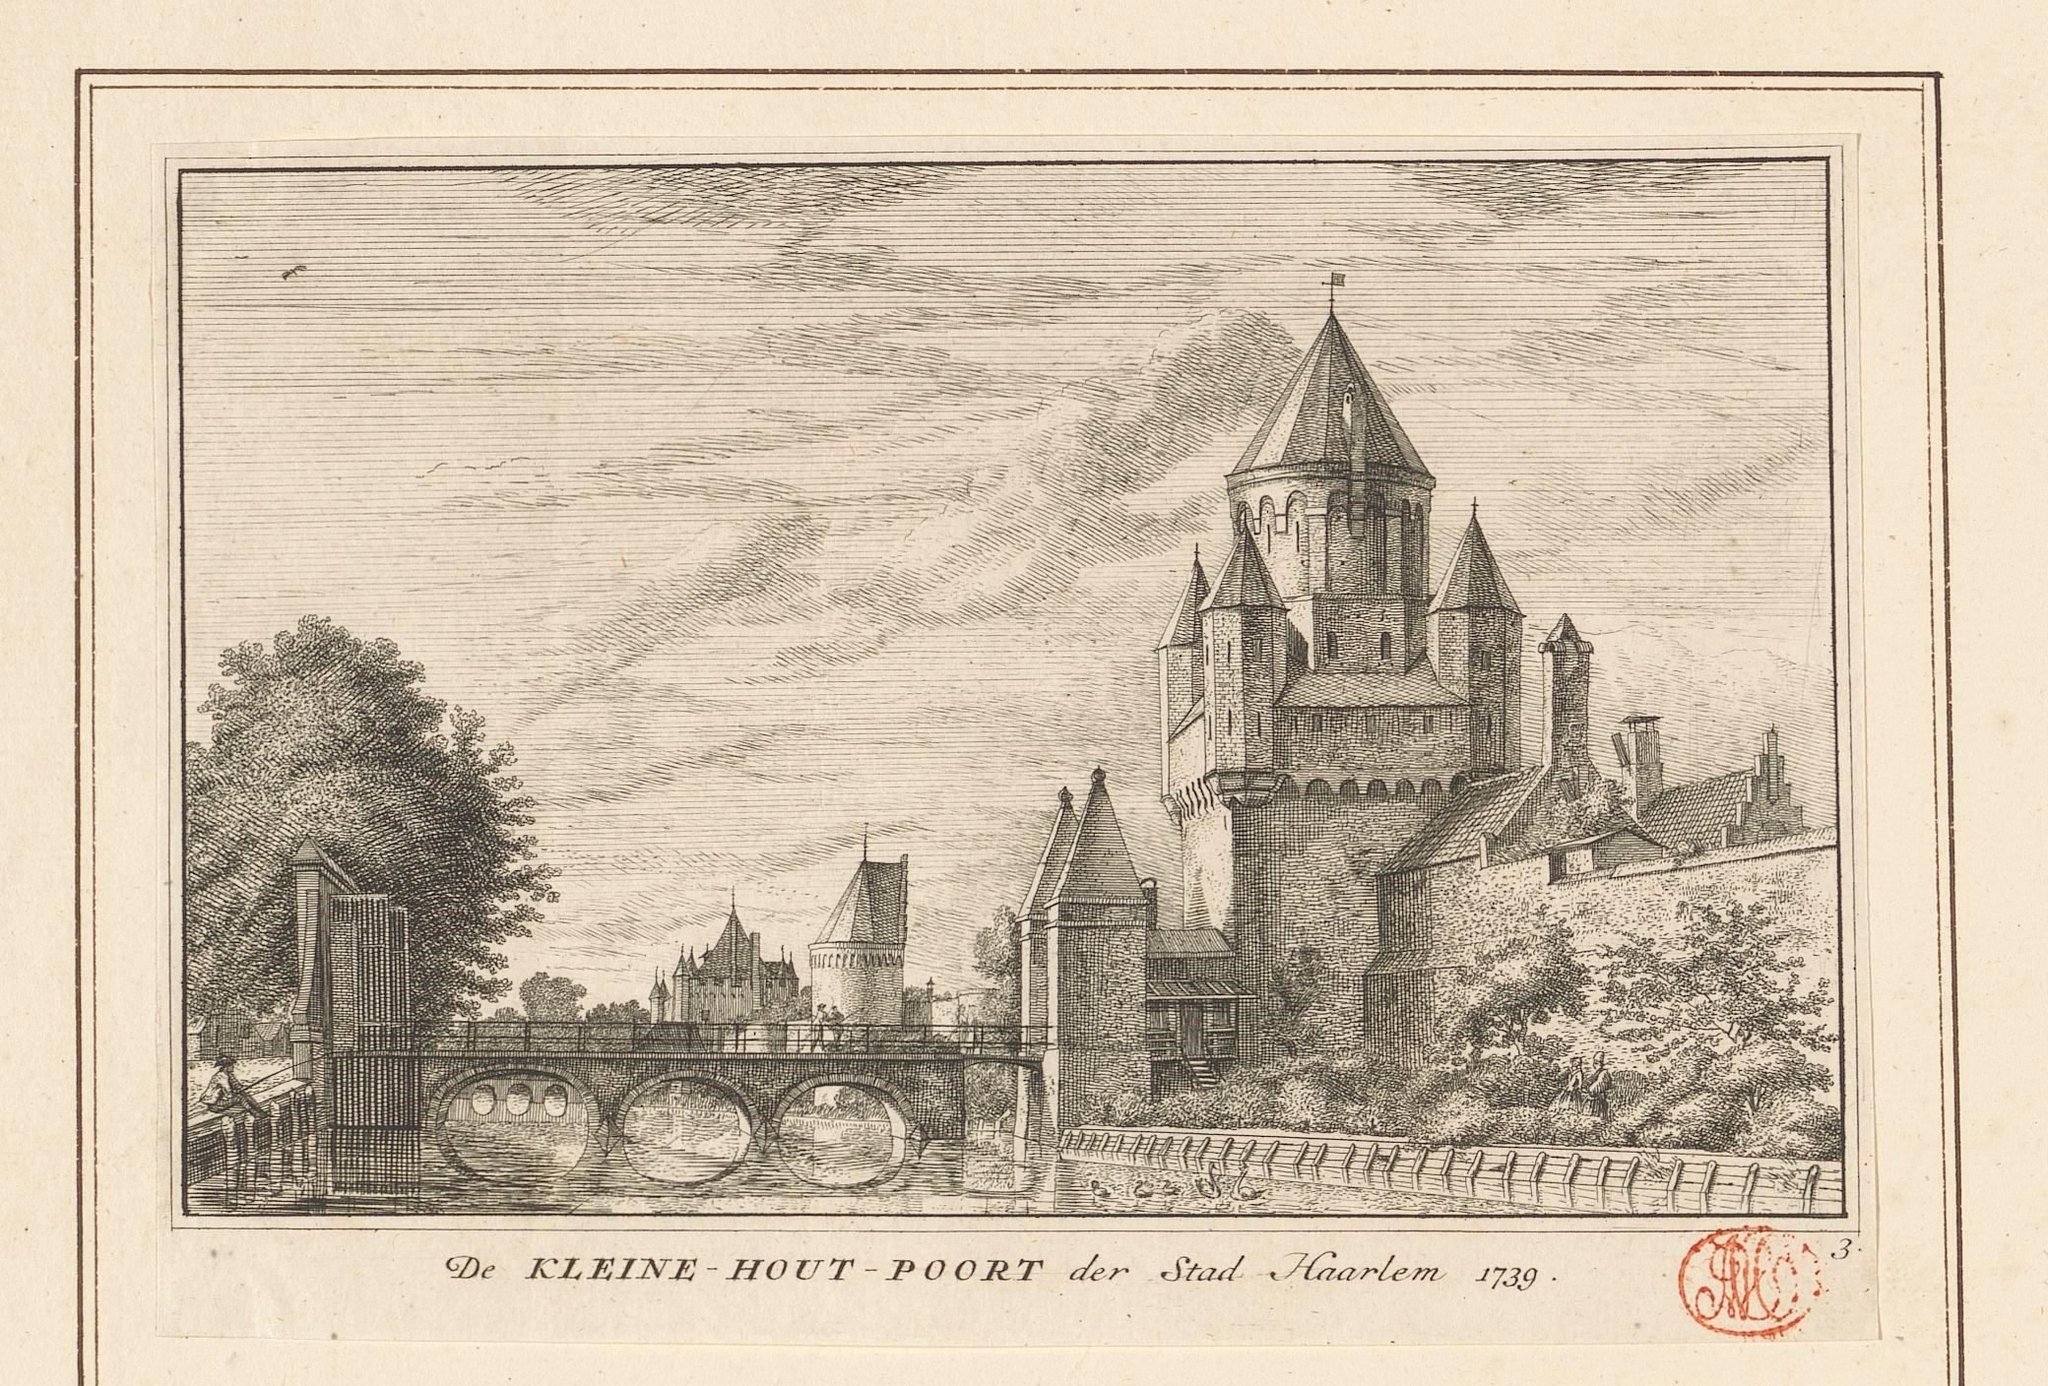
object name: print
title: Gezicht op de Kleine Houtpoort te Haarlem, 1739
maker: hendrik spilman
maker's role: draughtsman, painter, print maker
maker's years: 1721-1784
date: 1739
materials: paper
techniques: engraving, etching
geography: haarlem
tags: bridge, city-gate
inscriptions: collector's mark: Lugt 195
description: Gezicht op de Kleine Houtpoort te Haarlem, in de situatie omstreeks 1739. Rechtsonder genummerd: 3.